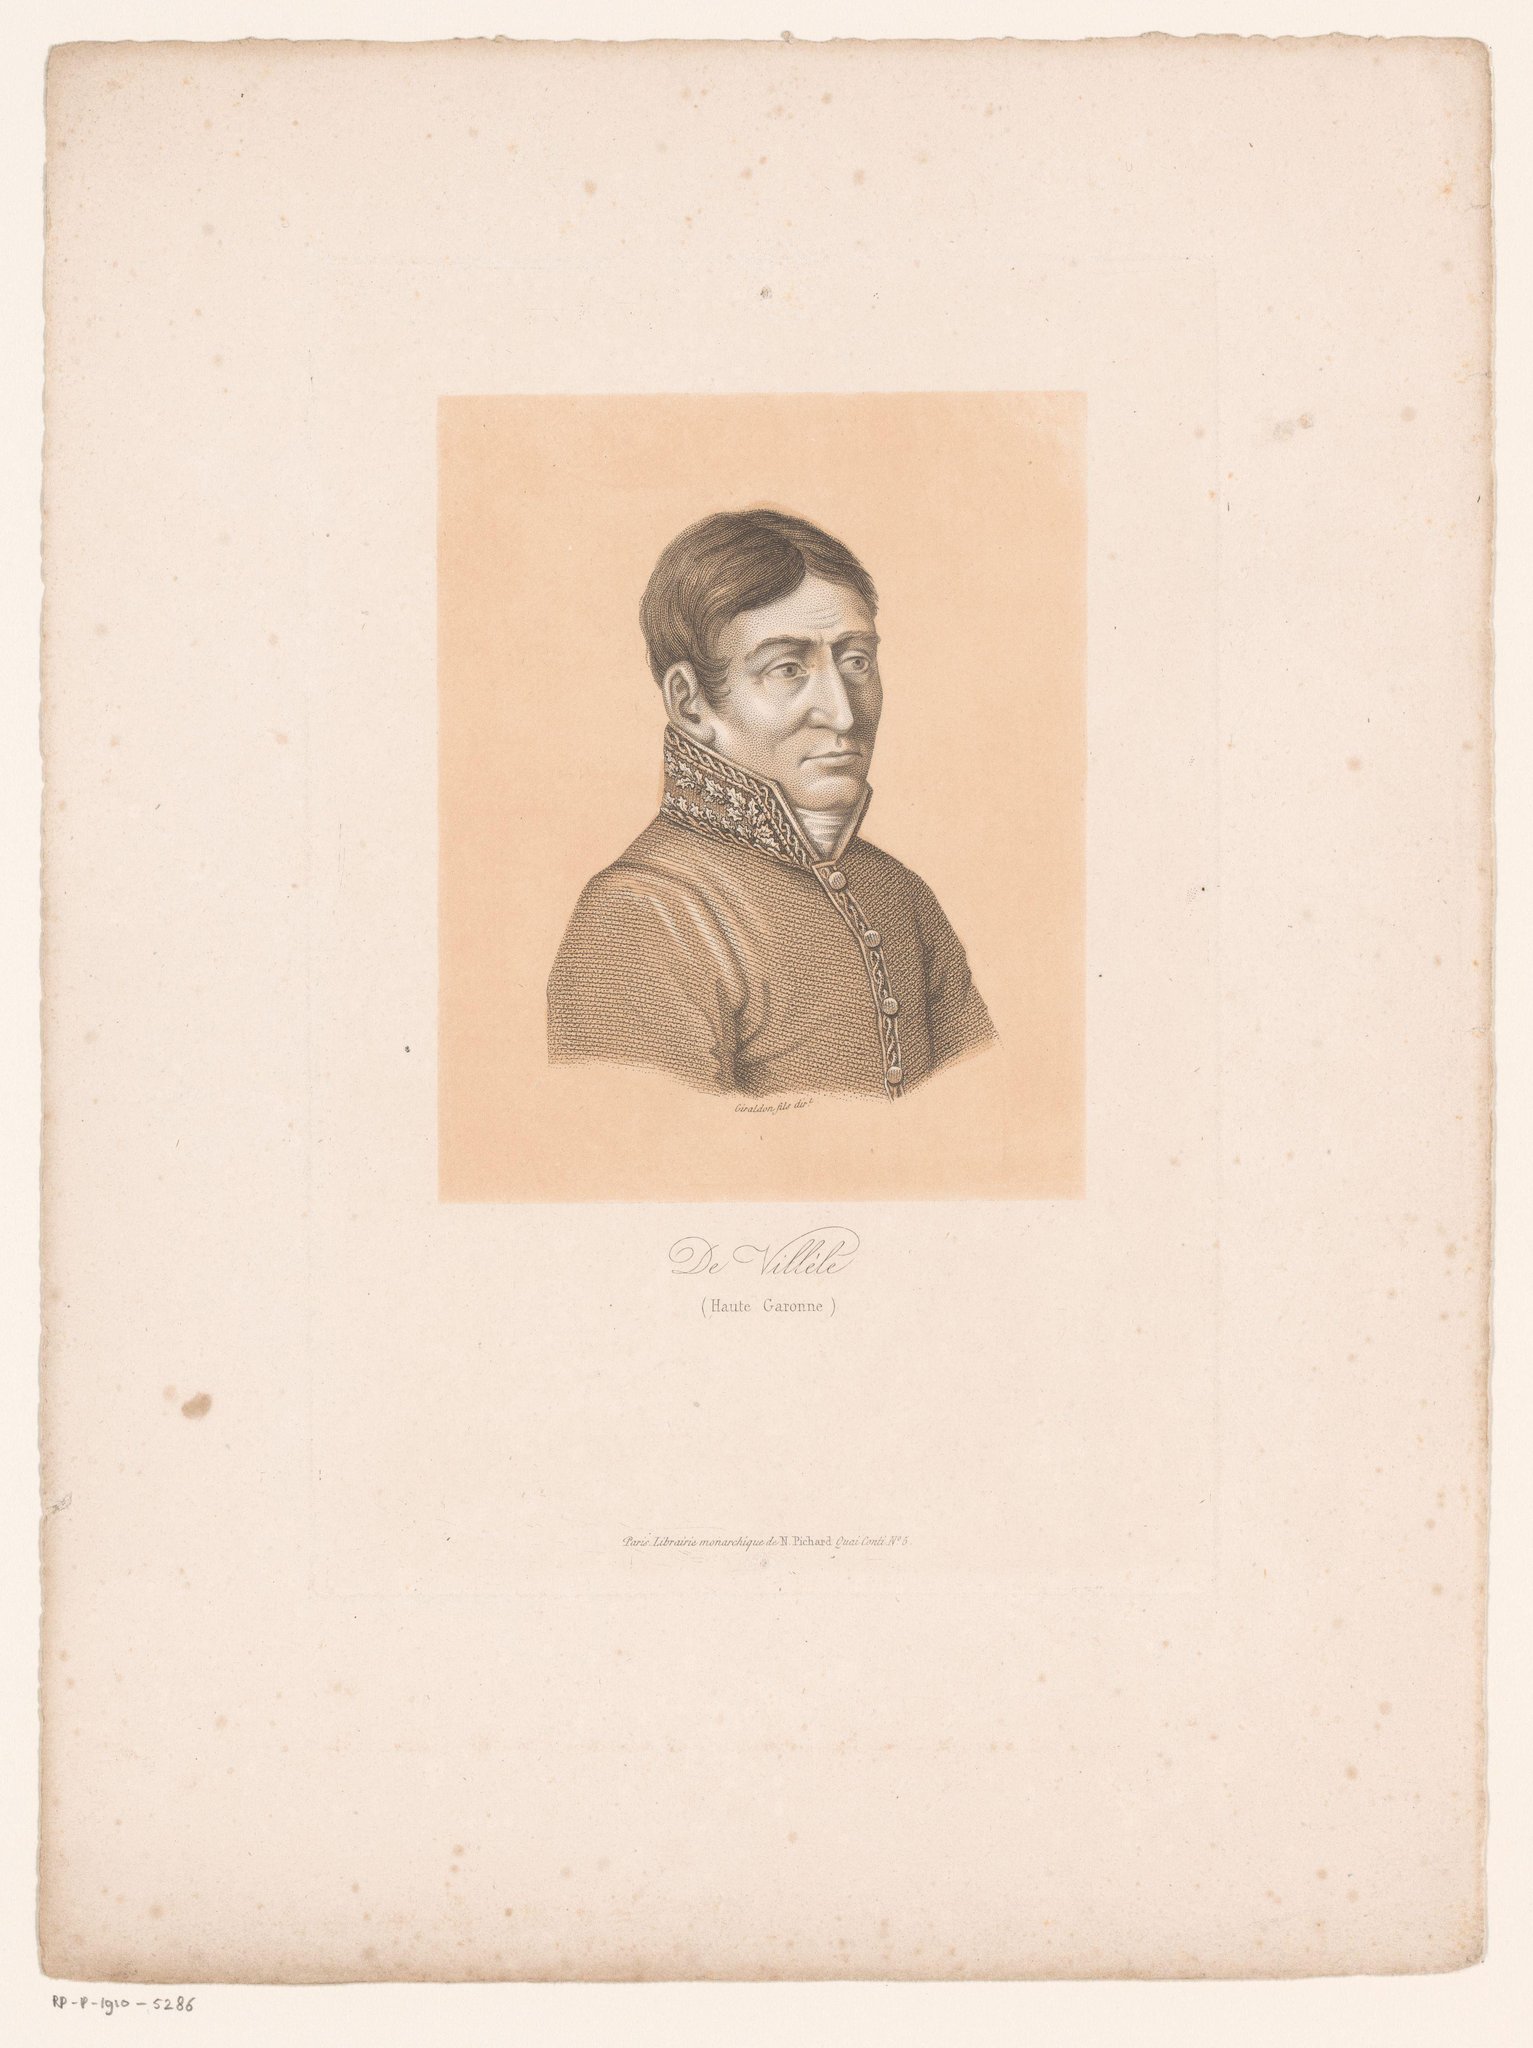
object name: print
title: Portret van Jean-Baptiste de Villèle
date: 1865-1910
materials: paper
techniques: engraving, lithograph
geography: paris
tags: mayor, historical persons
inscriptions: collector's mark: Lugt 2228